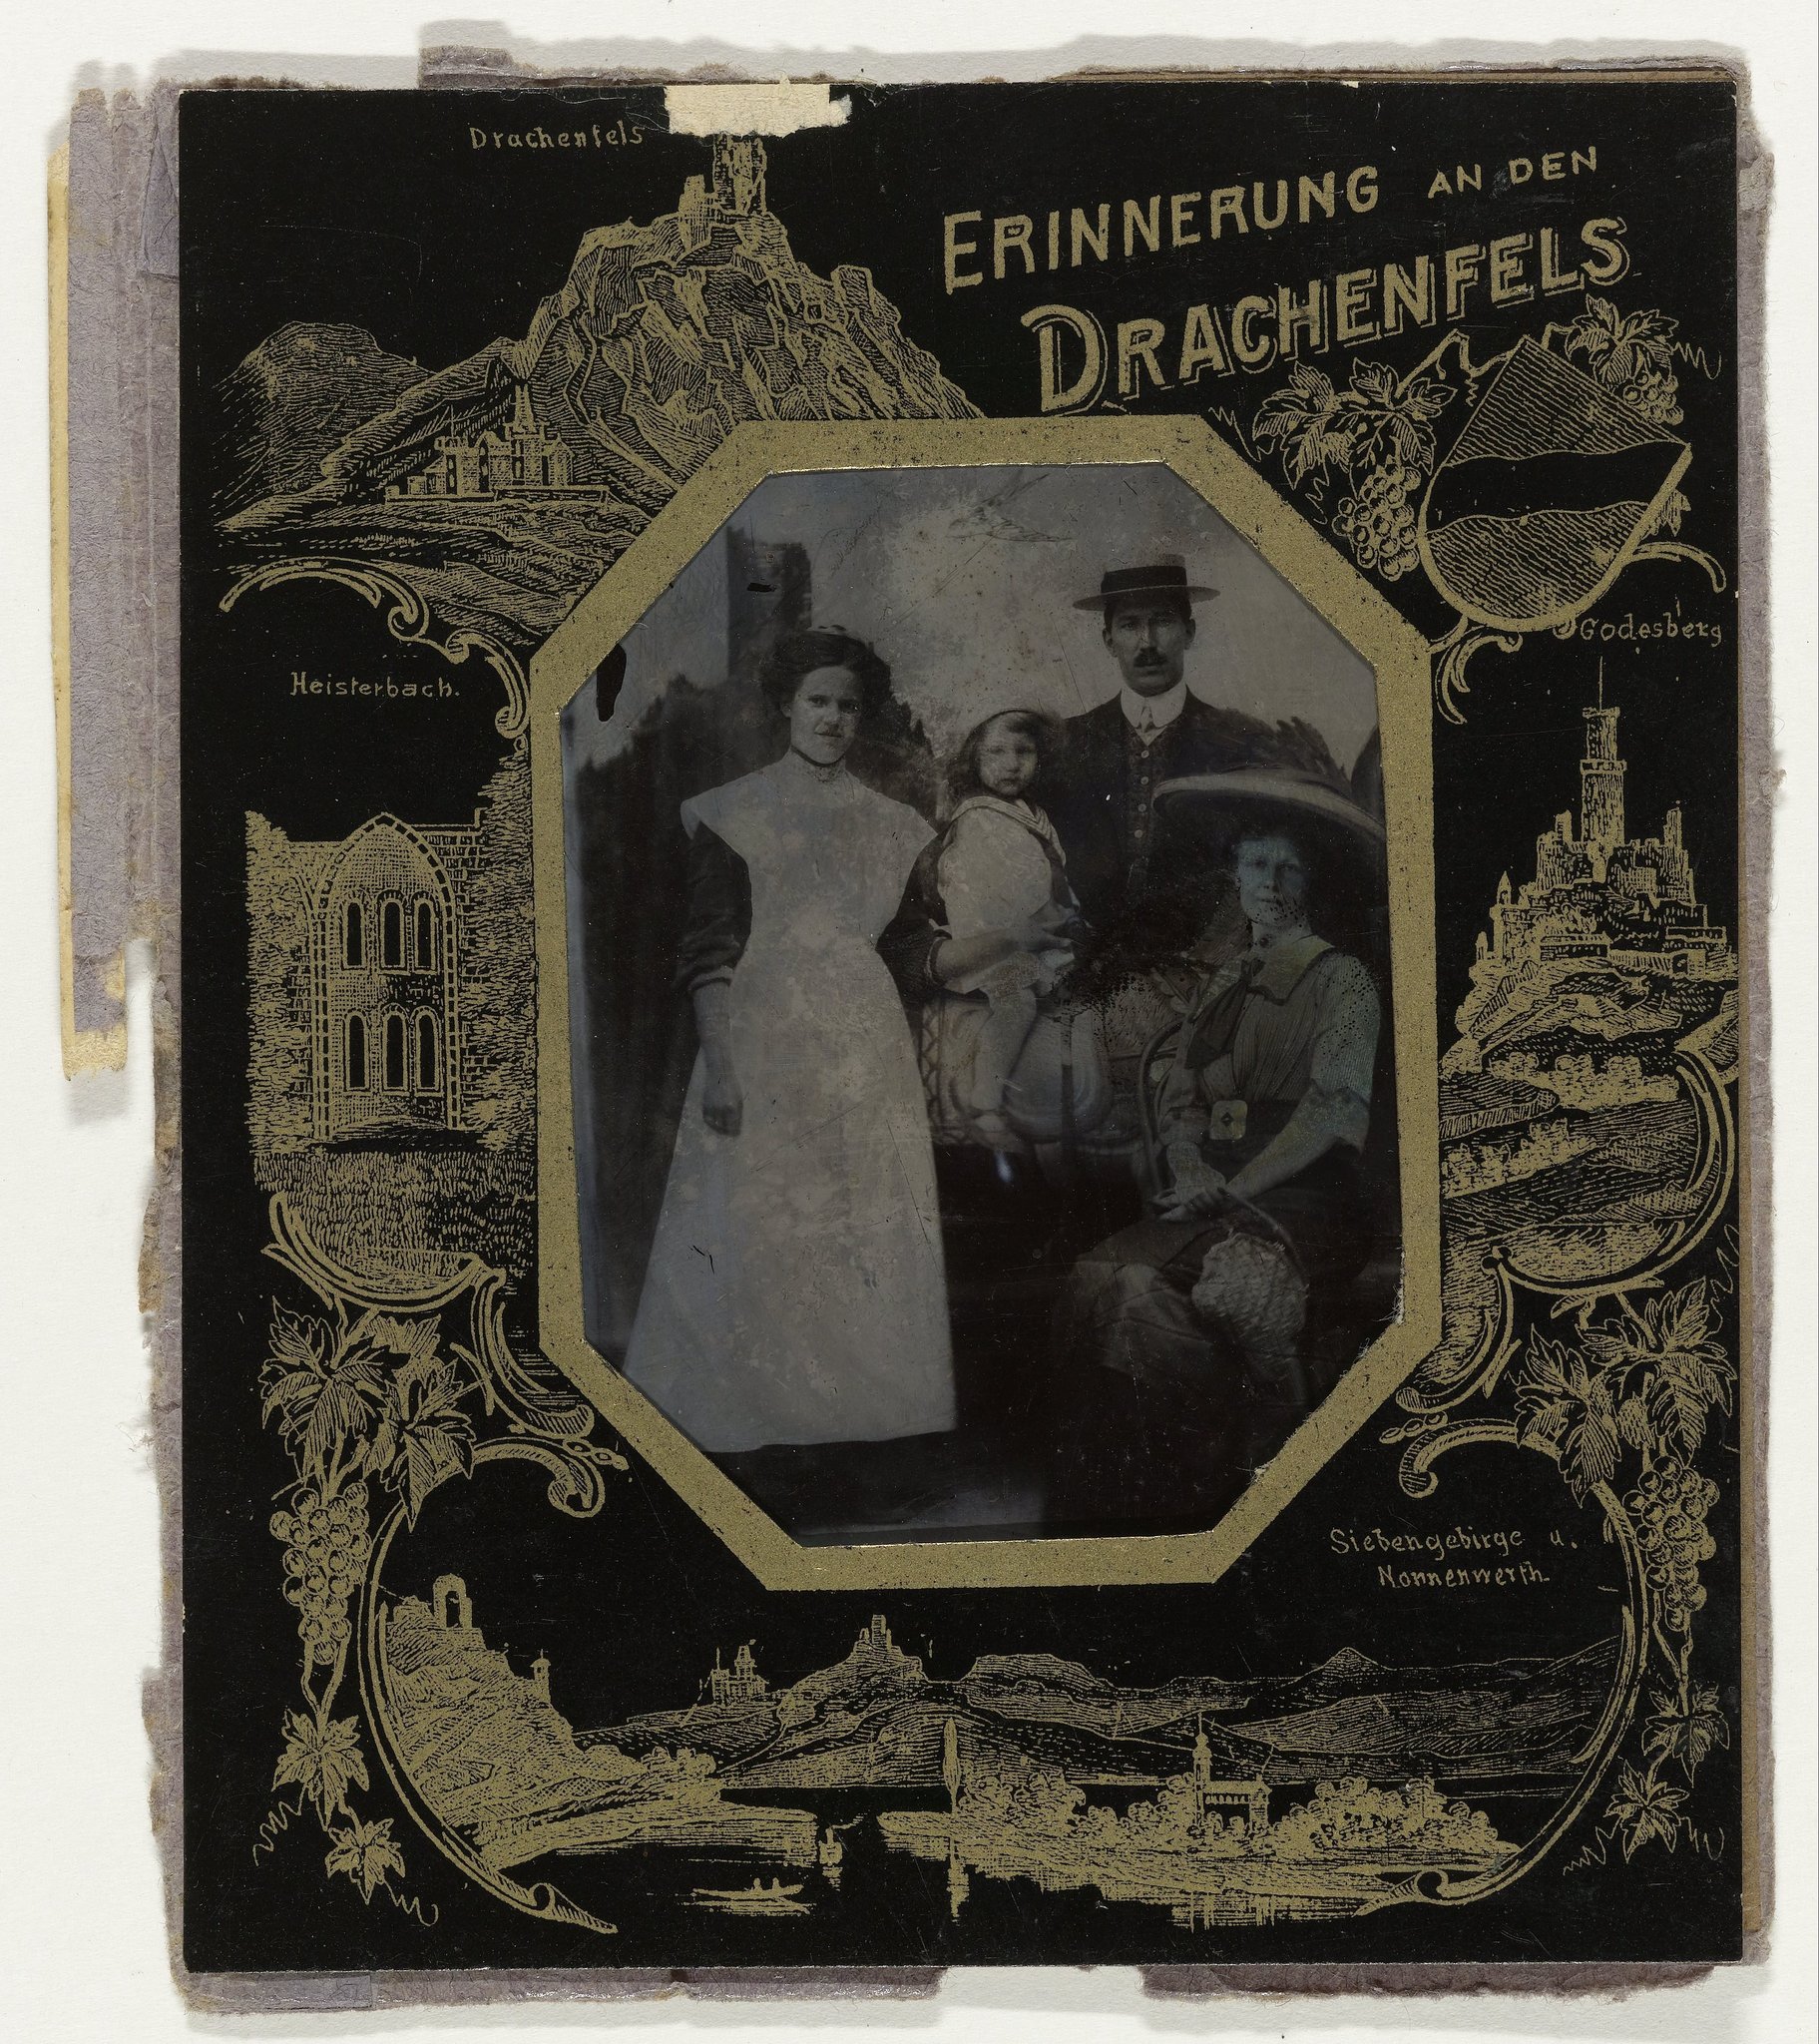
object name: photograph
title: Portret van een man, twee vrouwen en een meisje voor een geschilderd achtergronddoek met de Drachenfels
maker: Anonymous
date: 1890-1910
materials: metal, paper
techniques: ferrotyping, lithograph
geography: germany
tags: anonymous historical person portrayed, anonymous historical person portrayed - bb - woman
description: Portret van een man, twee vrouwen en een meisje voor een geschilderd achtergronddoek met de Drachenfels. In een papieren passpartout met lithografische voorstellingen van de Drachenfels, Heisterbach, Godesberg, Siebengebirge en Nonnenwerth.